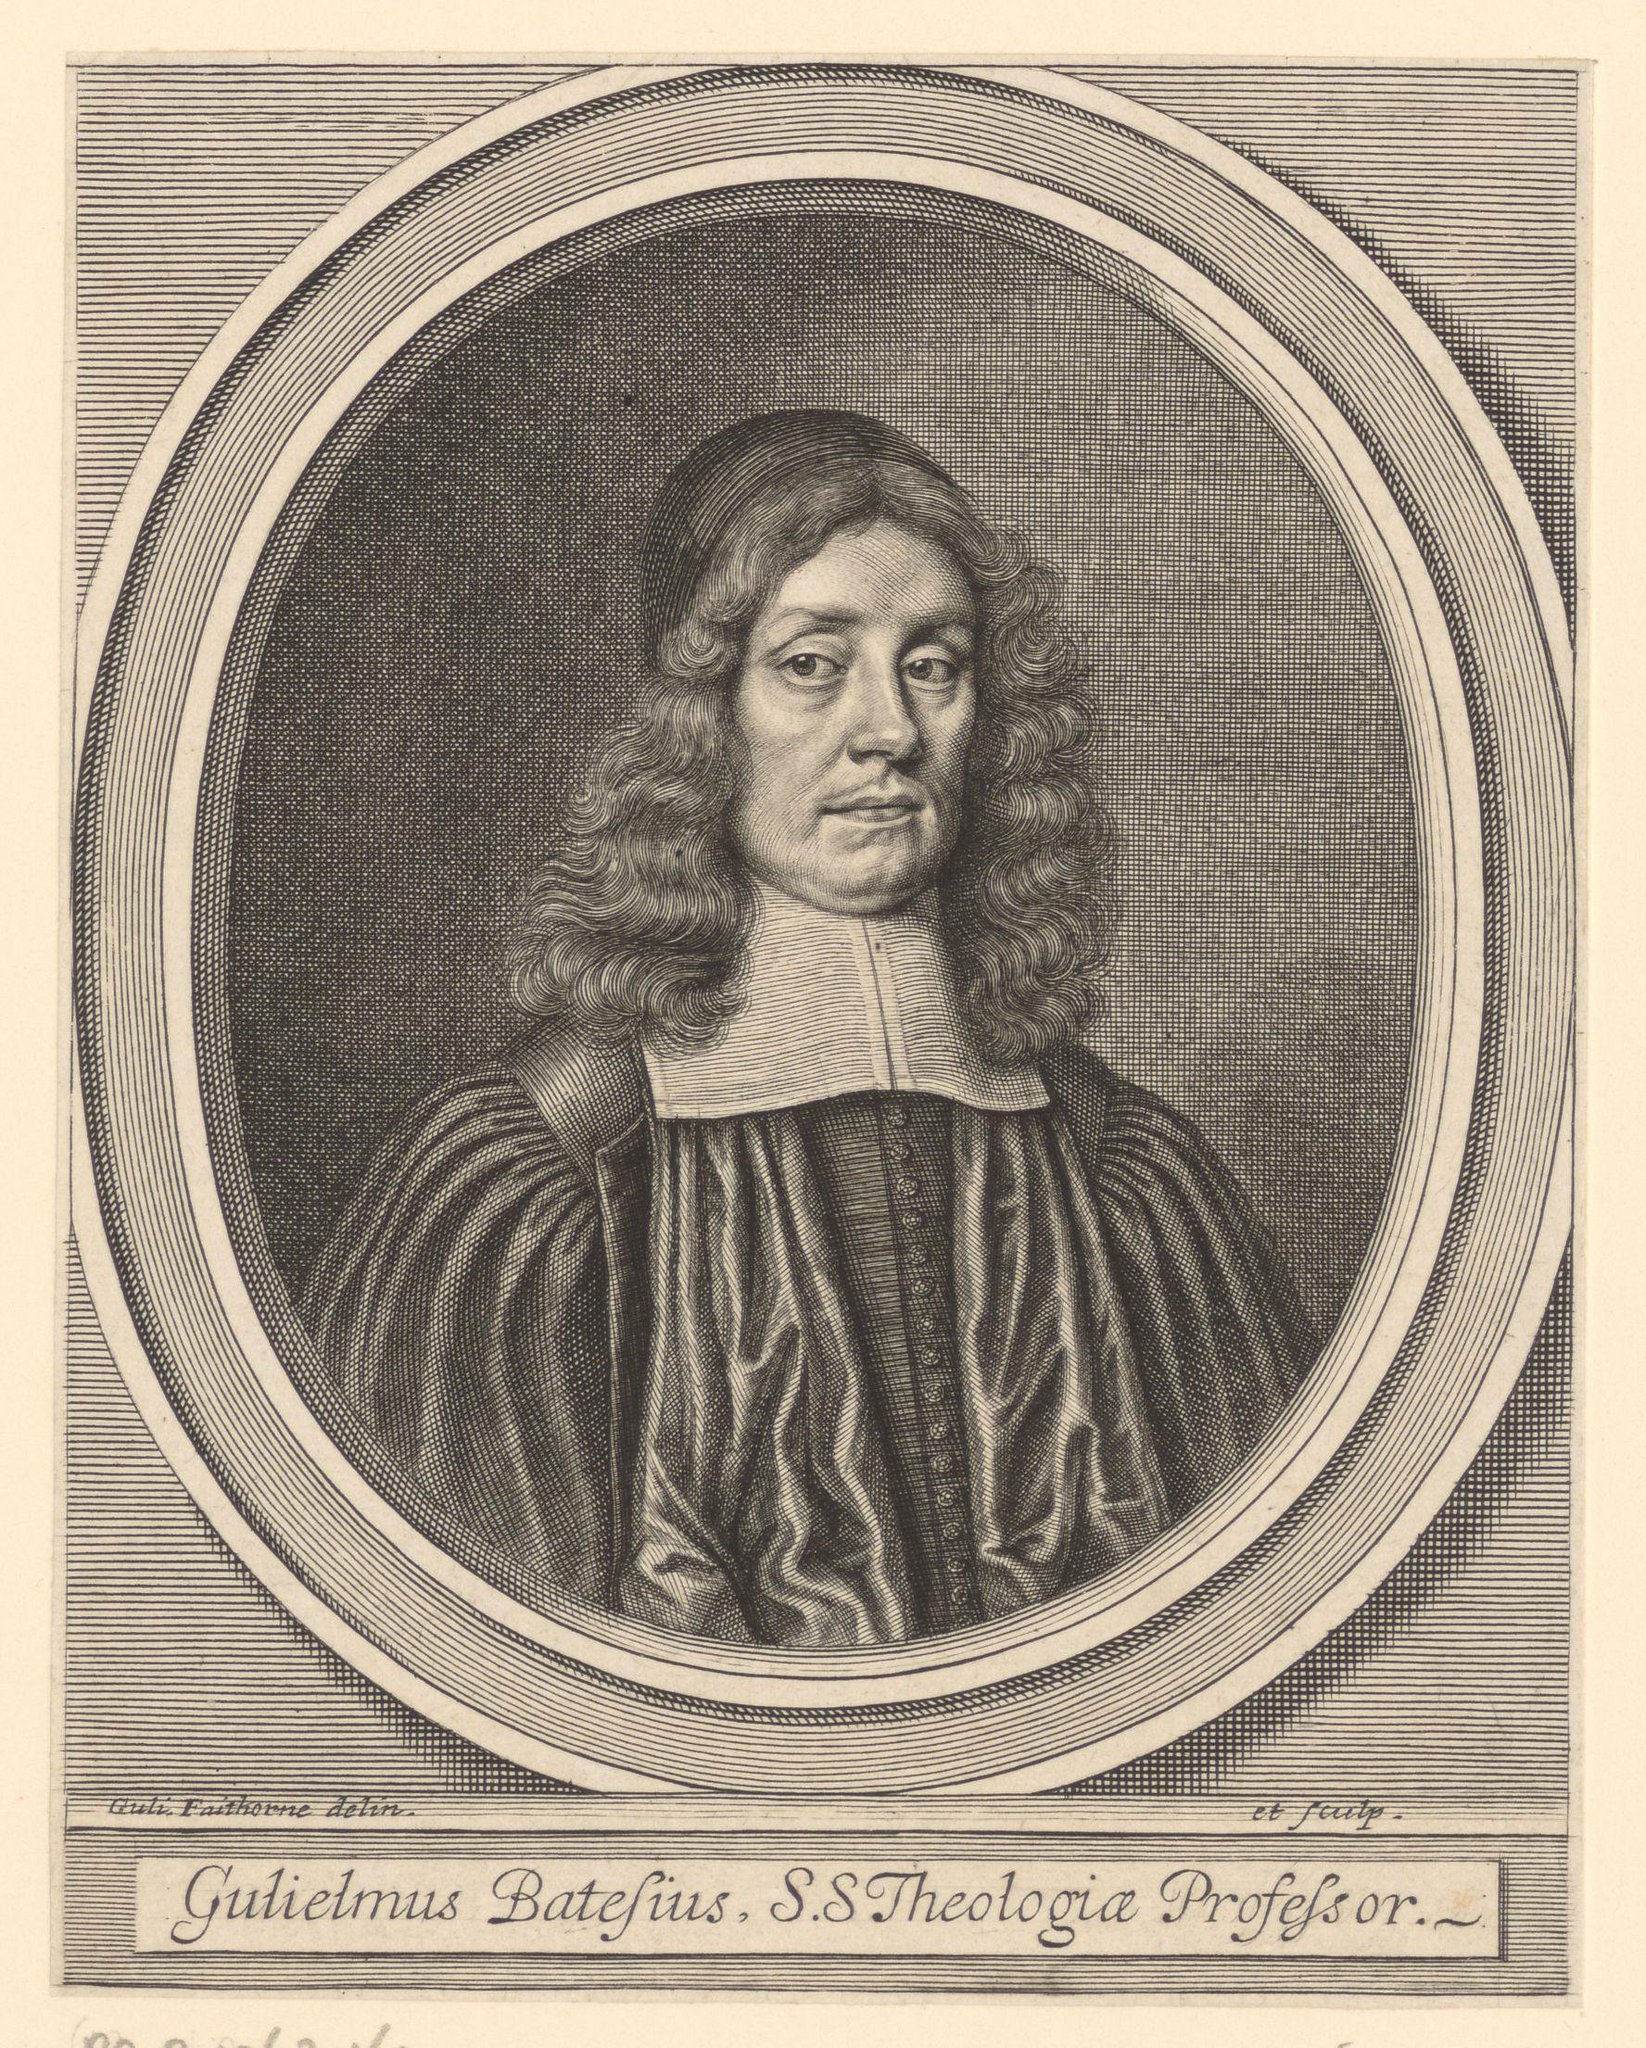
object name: print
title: Gulielmus Batesius, S.S. Theologia Professor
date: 1675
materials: paper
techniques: engraving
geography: london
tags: clergyman, functionaries and dignitaries (with name) ~ protestant churches, historical persons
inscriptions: collector's mark: Lugt 2760, collector's mark: Lugt 2228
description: Prent uit: Bates, William. The Harmony of the Divine Attributes (...). Londen: Nathanael Ranew et al., 1675.